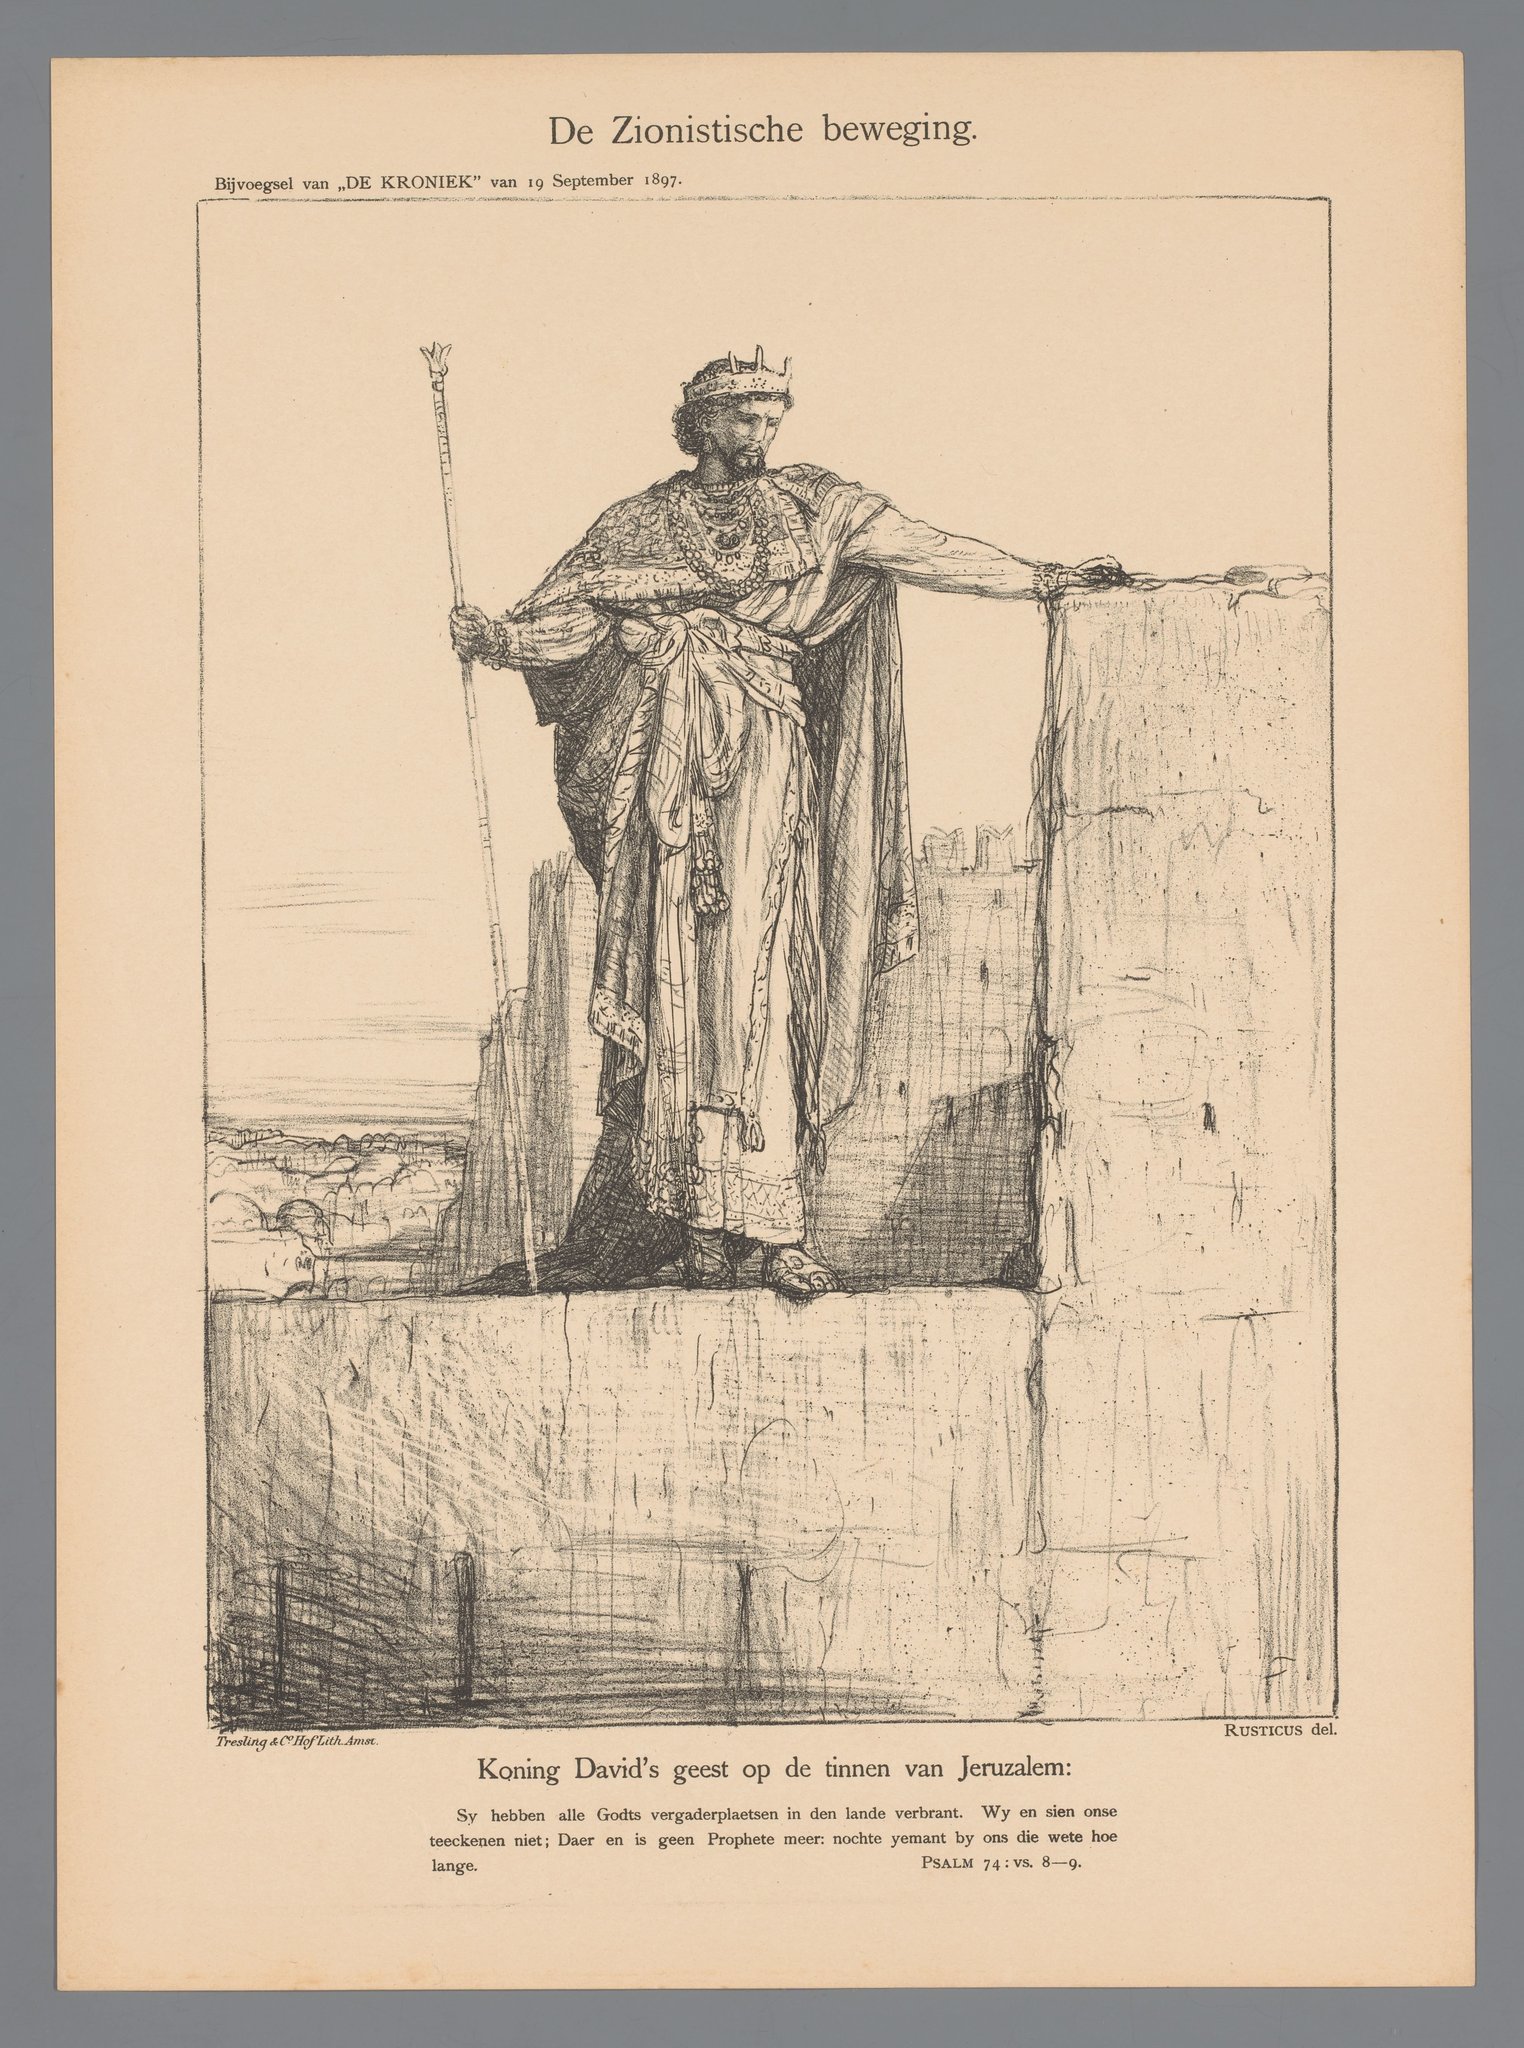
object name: print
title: De Zionistische beweging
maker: marius bauer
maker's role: draughtsman, print maker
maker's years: 1867-1932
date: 1897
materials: paper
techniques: lithograph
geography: amsterdam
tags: the jews, jewish life, political caricatures and satires, jewish religion and culture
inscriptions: date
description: Spotprent op de oprichting van de Zionistische Beweging in 1897. Koning David staande op de muren van Jeruzalem. Onderaan een citaat uit Psalm 74.